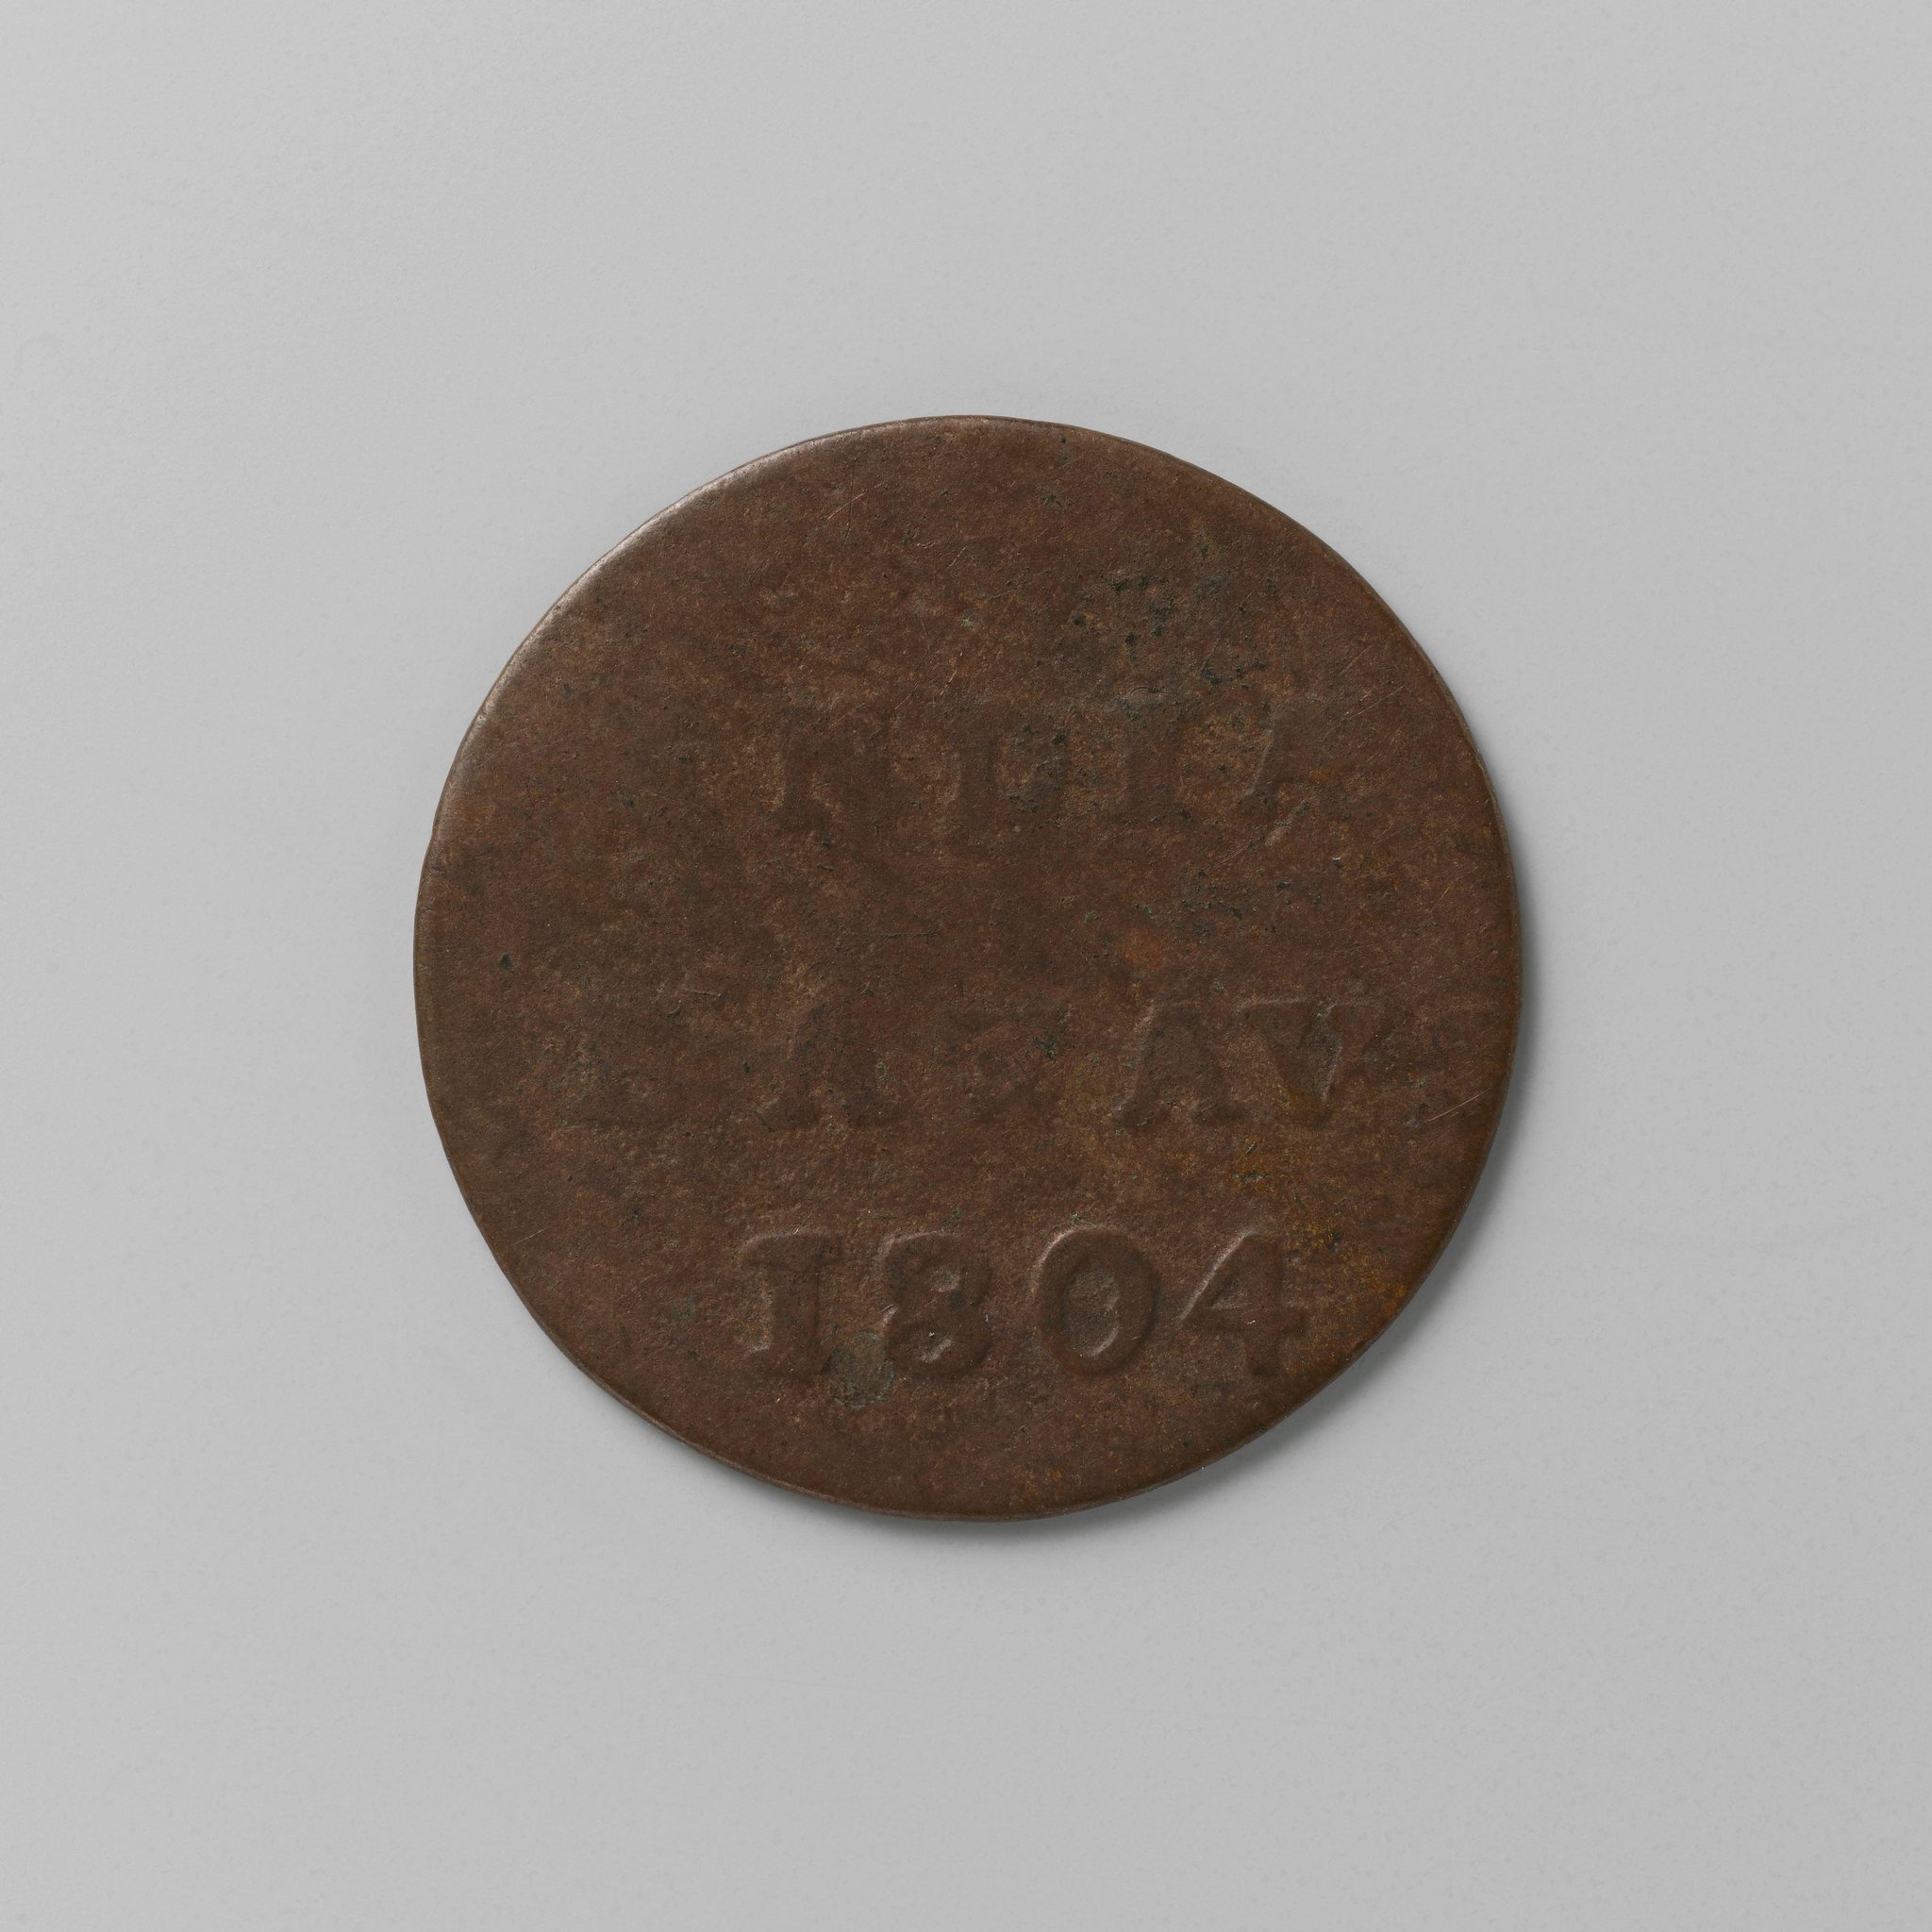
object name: coin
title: Nederlands Indië, ½ duit Holland, 1804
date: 1804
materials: copper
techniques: striking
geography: hoorn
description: Koperen munt. Voorzijde: tweeregelig opschrift, waarboven muntteken ster en waaronder jaartal. Keerzijde: tussen waarde-aanduiding 5 1/32 G gekroond generaliteitswapenschild. Gladde rand.